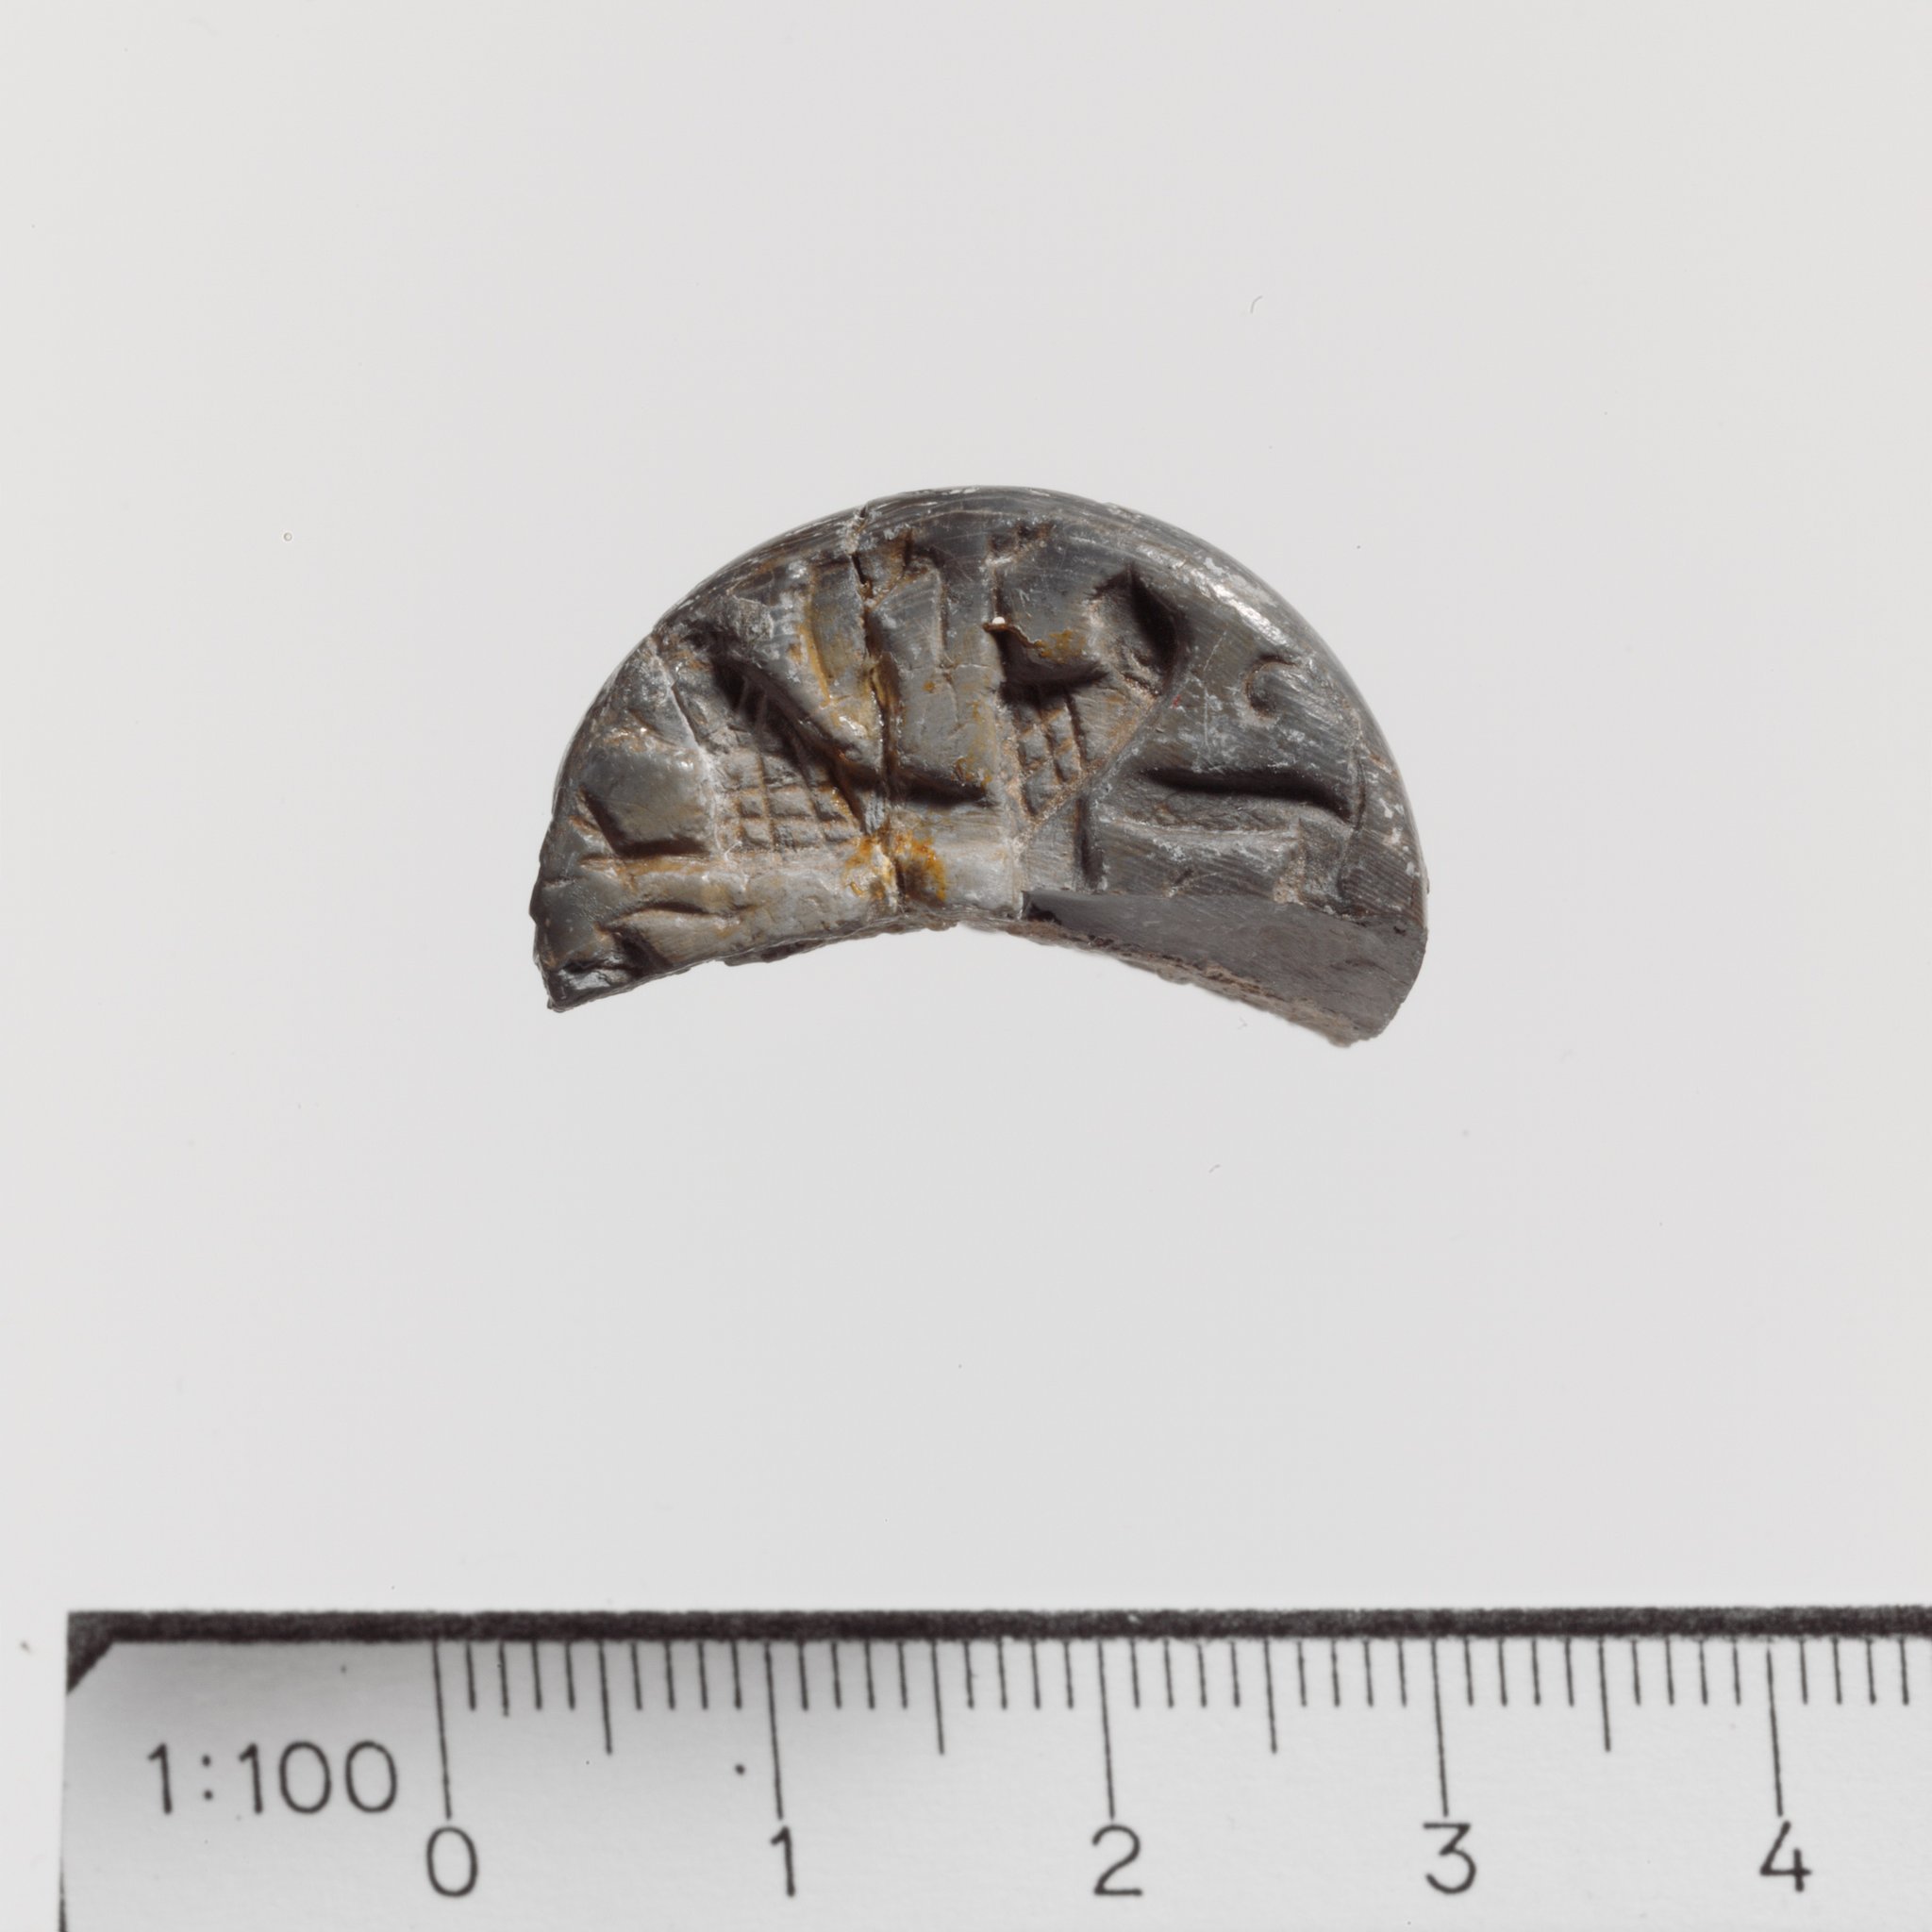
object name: seal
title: Ivory truncated conoid seal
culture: minoan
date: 2400-2200 BCE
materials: ivory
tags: lions